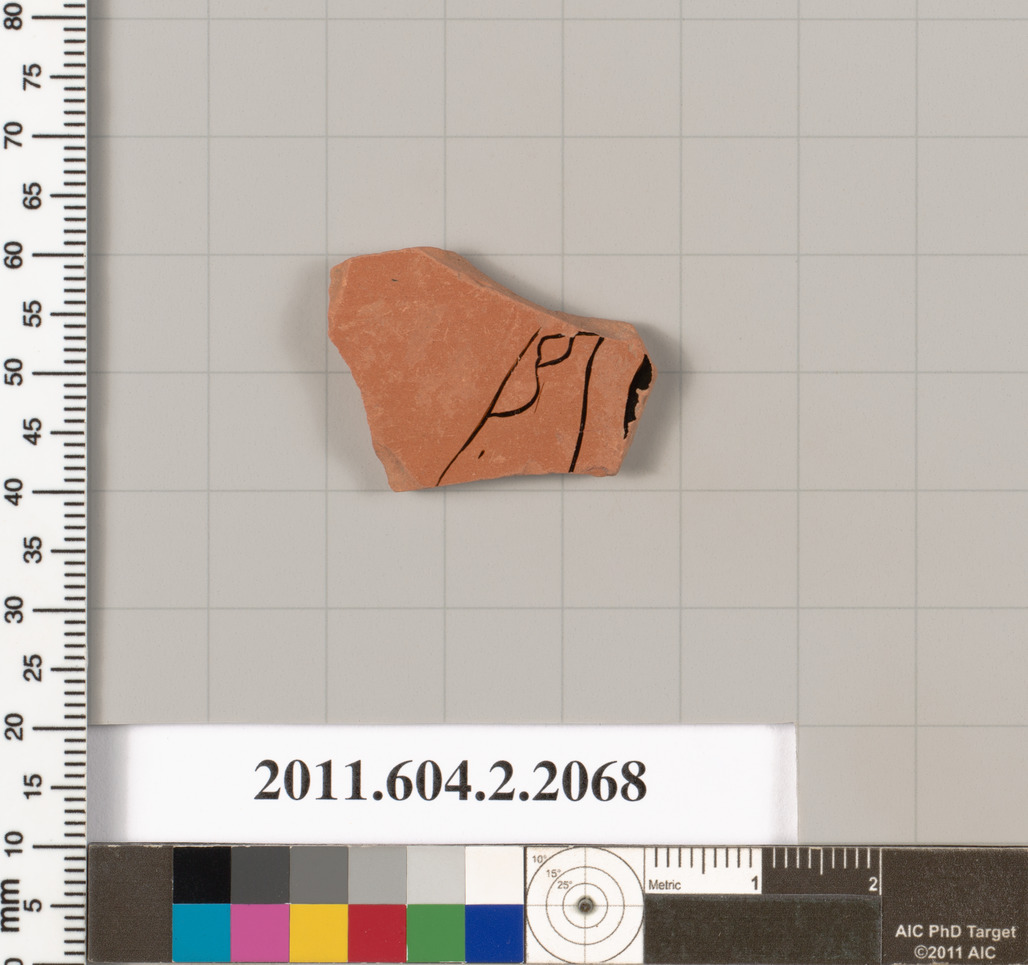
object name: pot fragment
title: Terracotta fragment of a pot; glazed on the inside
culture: greek, attic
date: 475-451 BCE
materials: terracotta